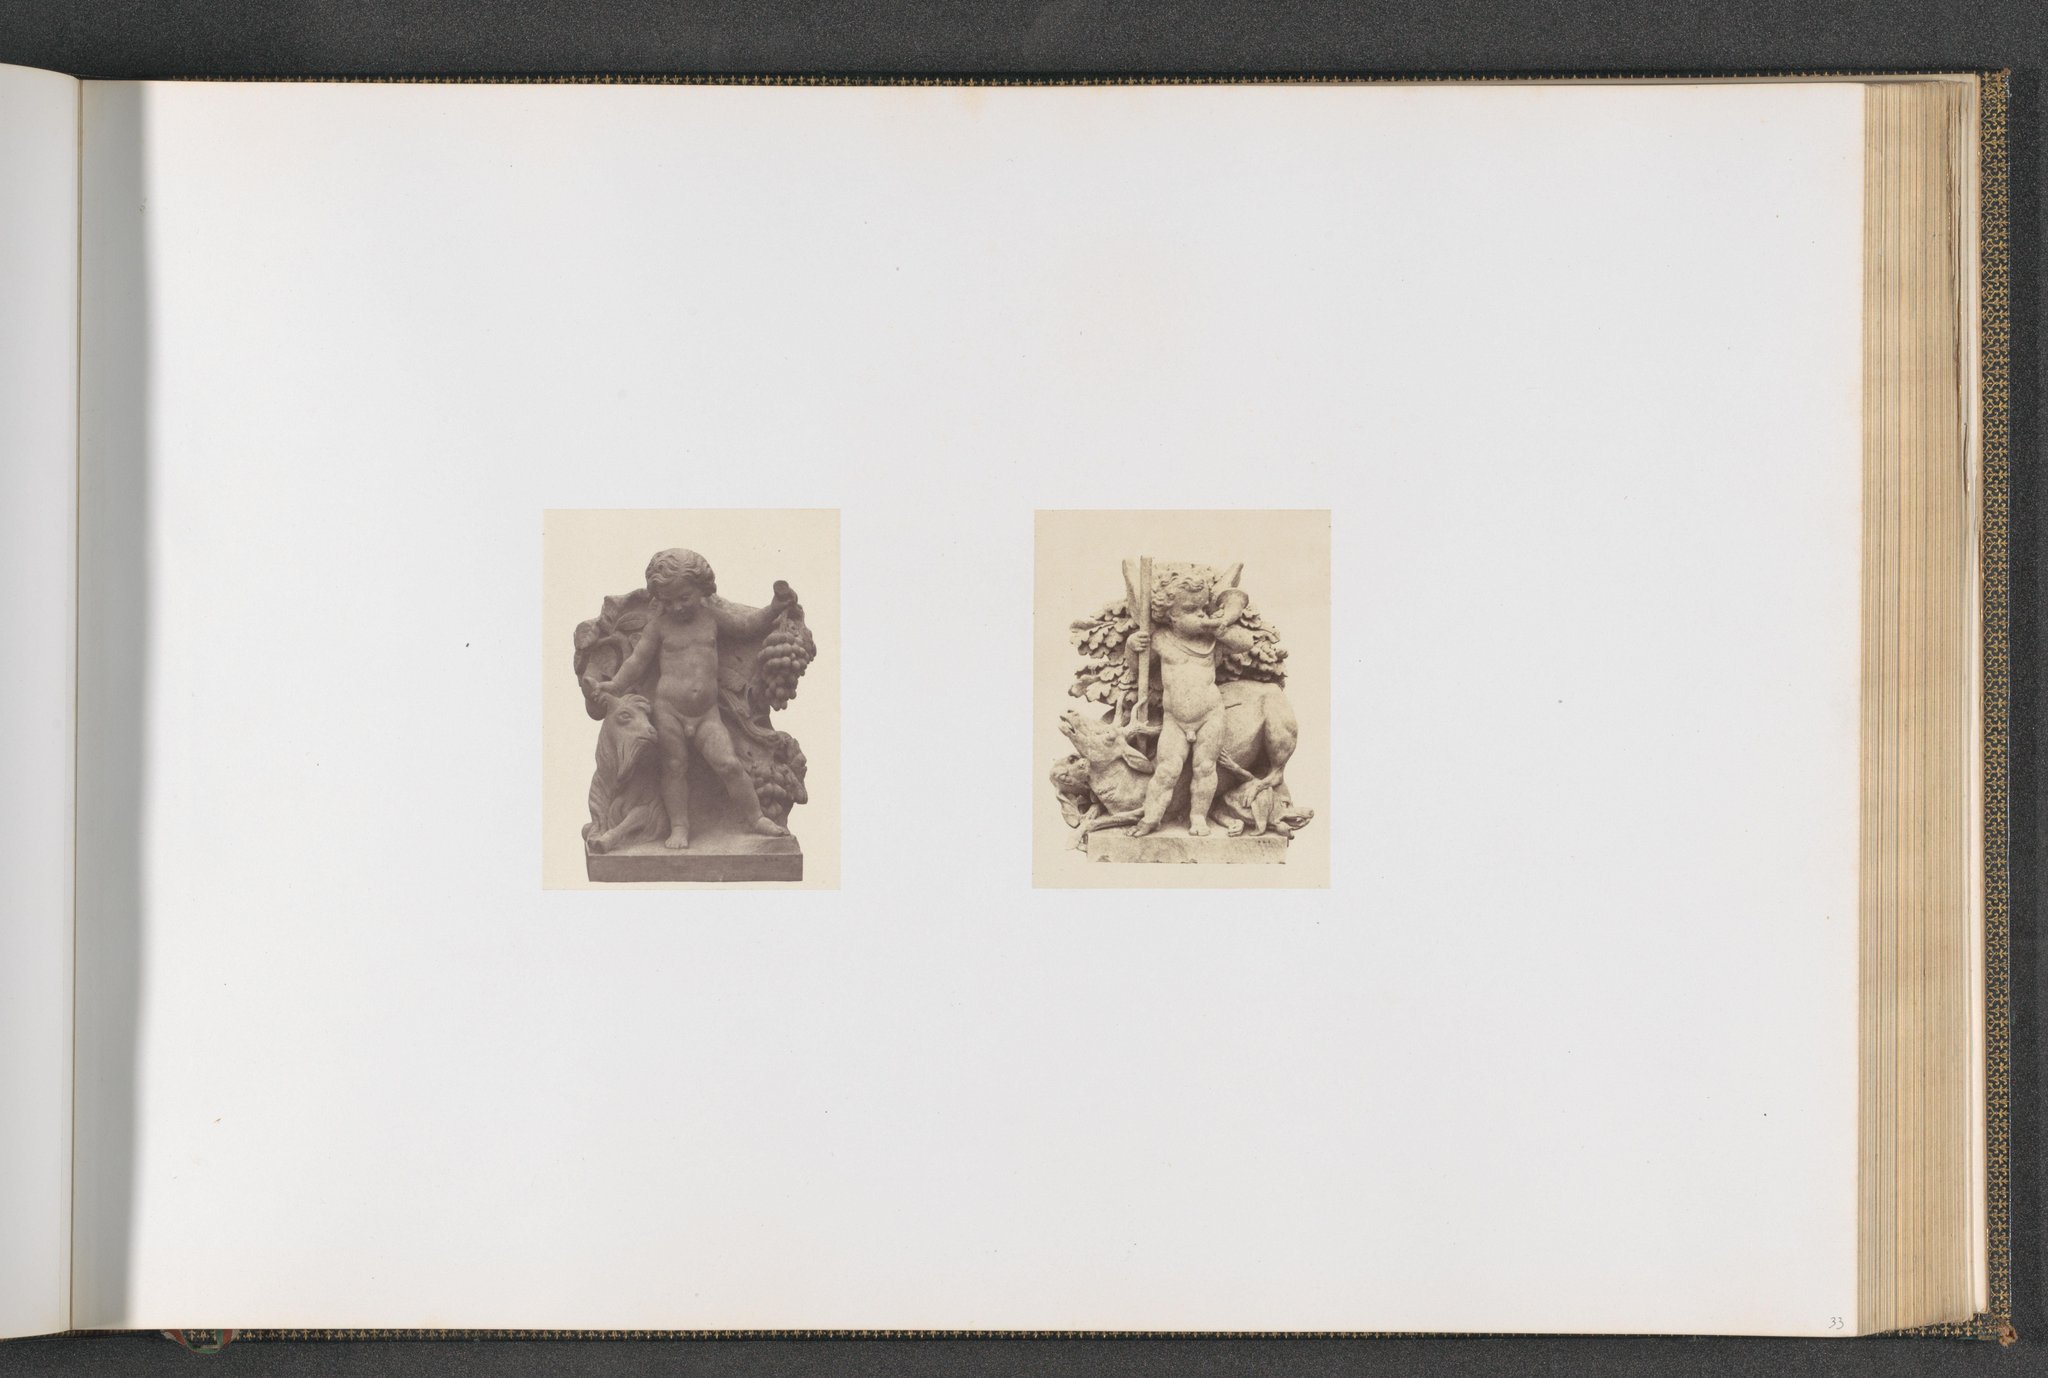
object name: photograph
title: Gipsmodellen voor beeldhouwwerken op het Palais du Louvre: links "L'Automne" door François Truphème en rechts "La Chasse" Alexandre Schoenewerk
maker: édouard denis baldus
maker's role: fotograaf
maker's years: 1813-1889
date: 1855-1857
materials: paper, photographic support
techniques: salted paper print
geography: paris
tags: piece of sculpture, reproduction of a piece of sculpture, permanent exhibition, museum, paris, tuileries palace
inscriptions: number: ‘950 en 961’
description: Onderdeel van Réunion des Tuileries au Louvre 1852-1857, album 2.